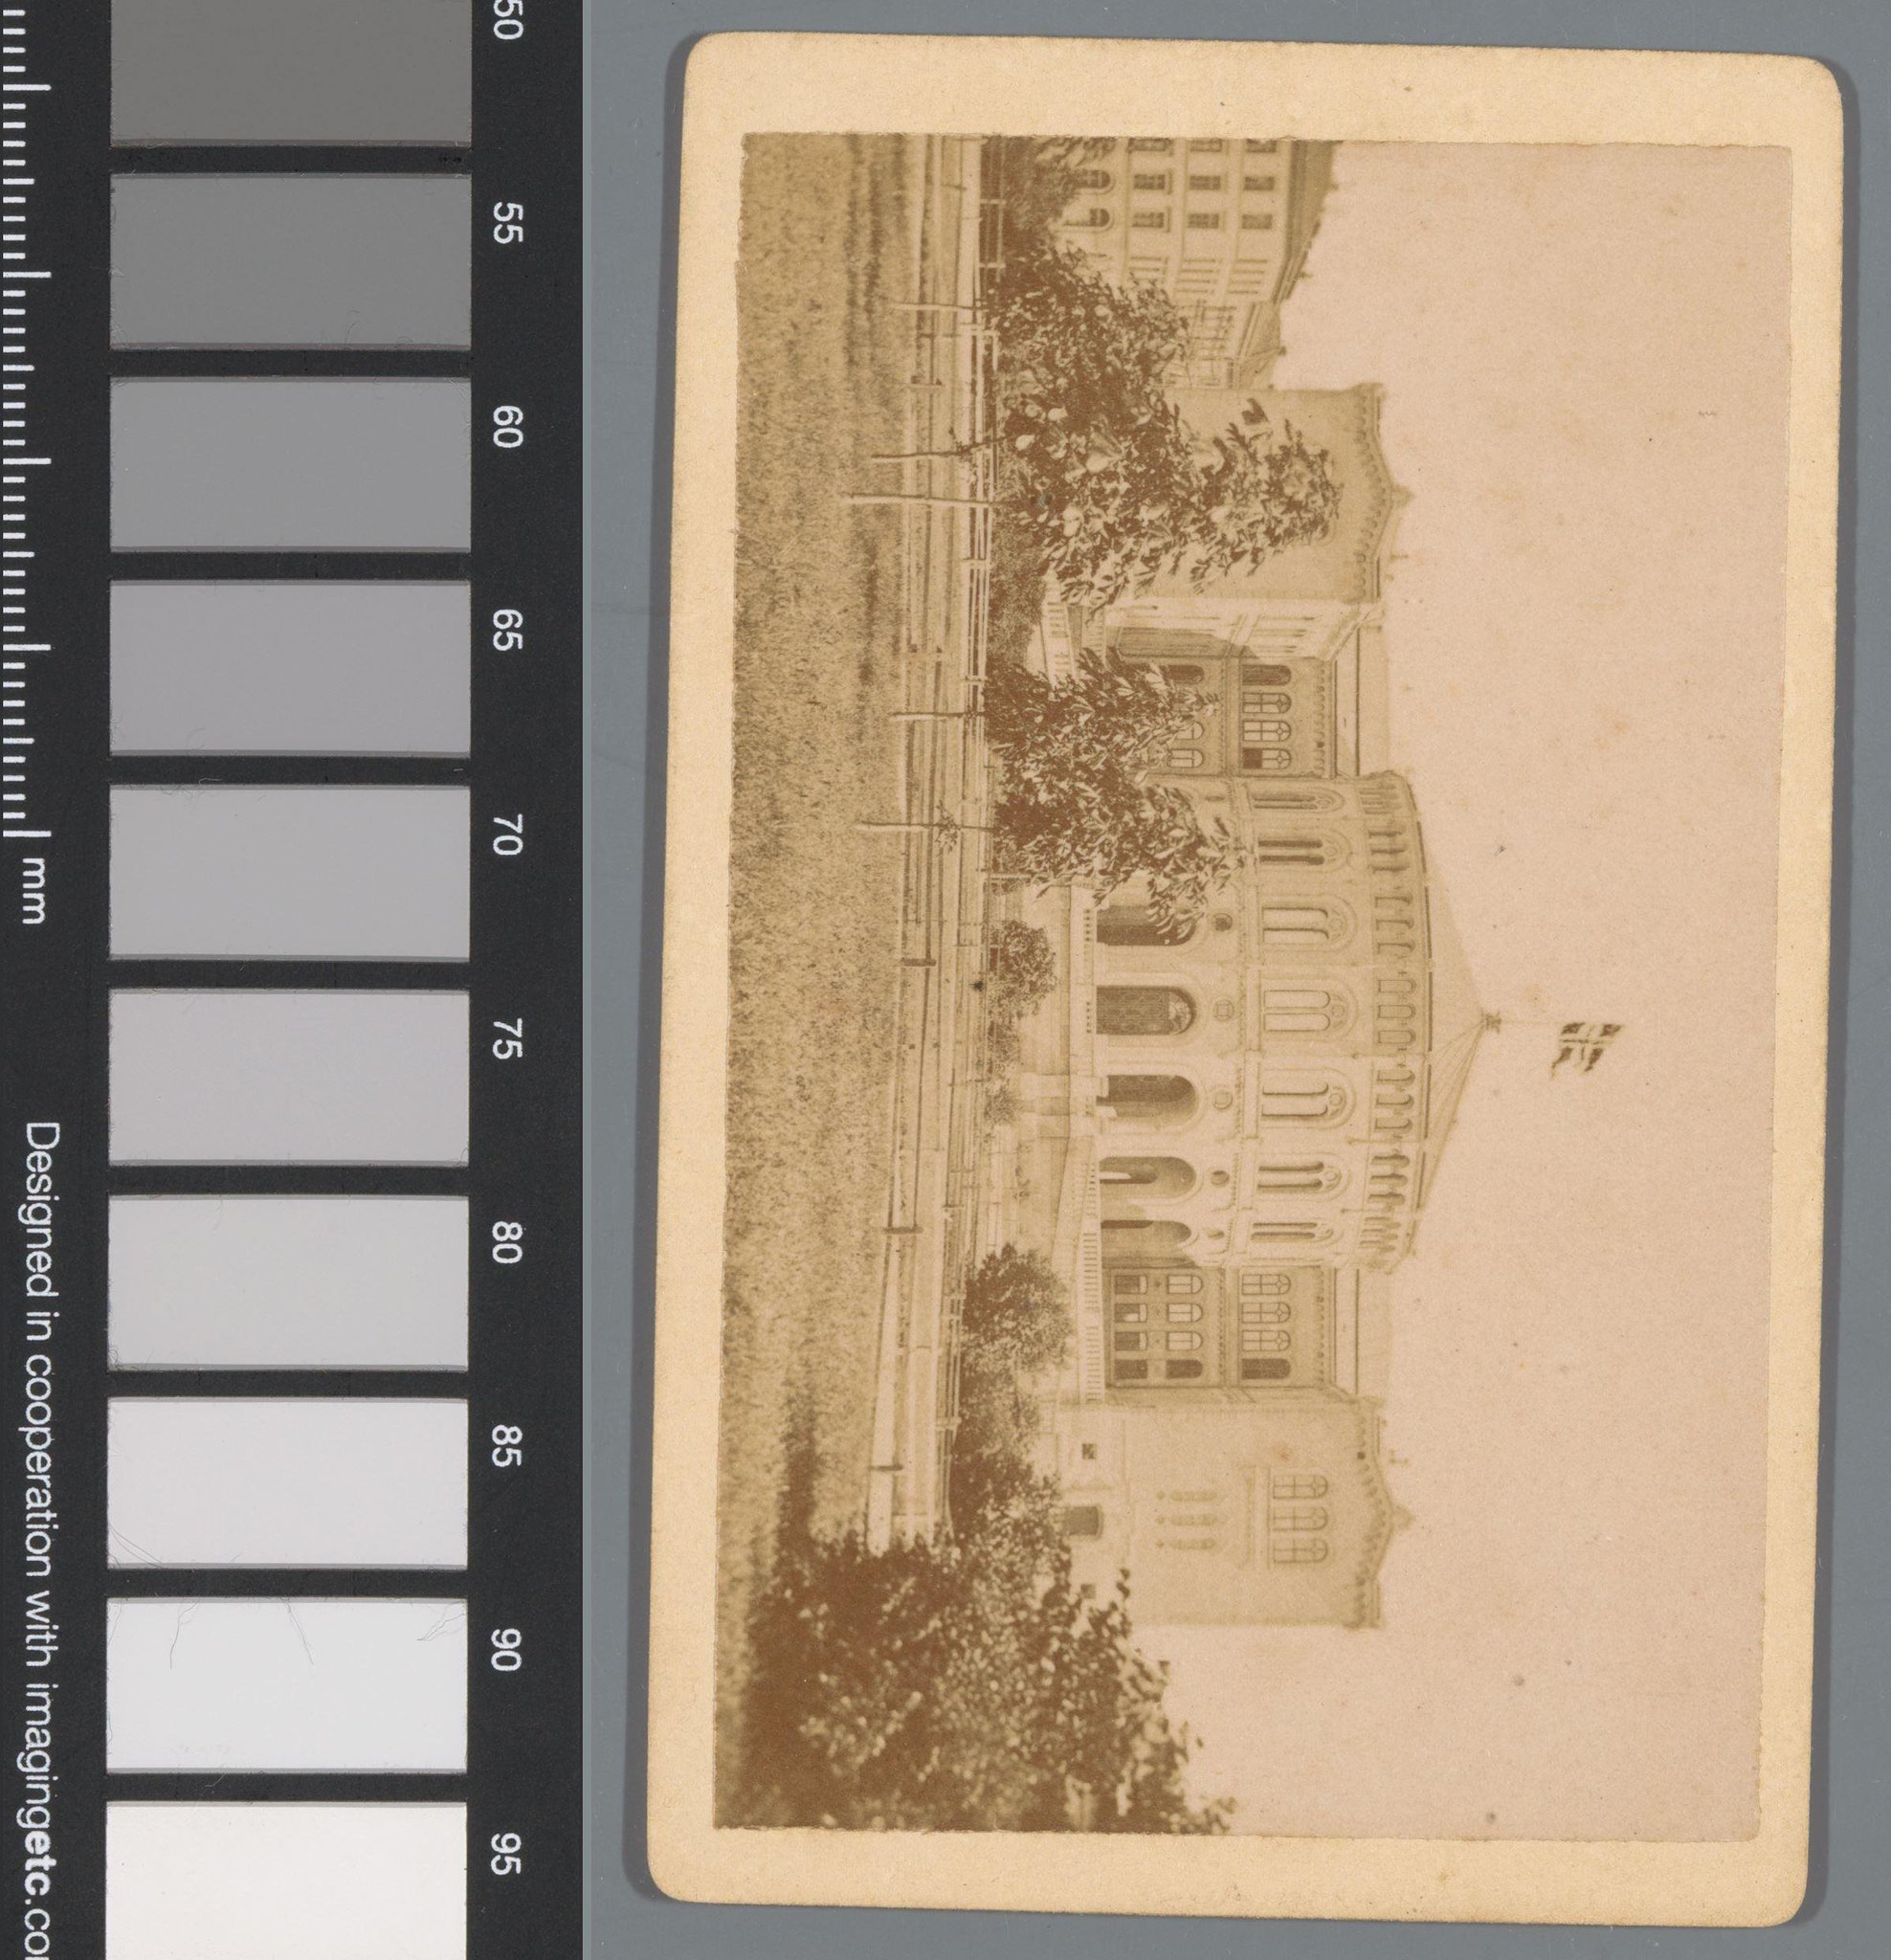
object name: carte de visite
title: Christiania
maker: olaf martin peder væring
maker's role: fotograaf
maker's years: 1837-1906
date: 1879-1906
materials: cardboard, paper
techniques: albumen print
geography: oslo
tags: lower house, parliament, chamber